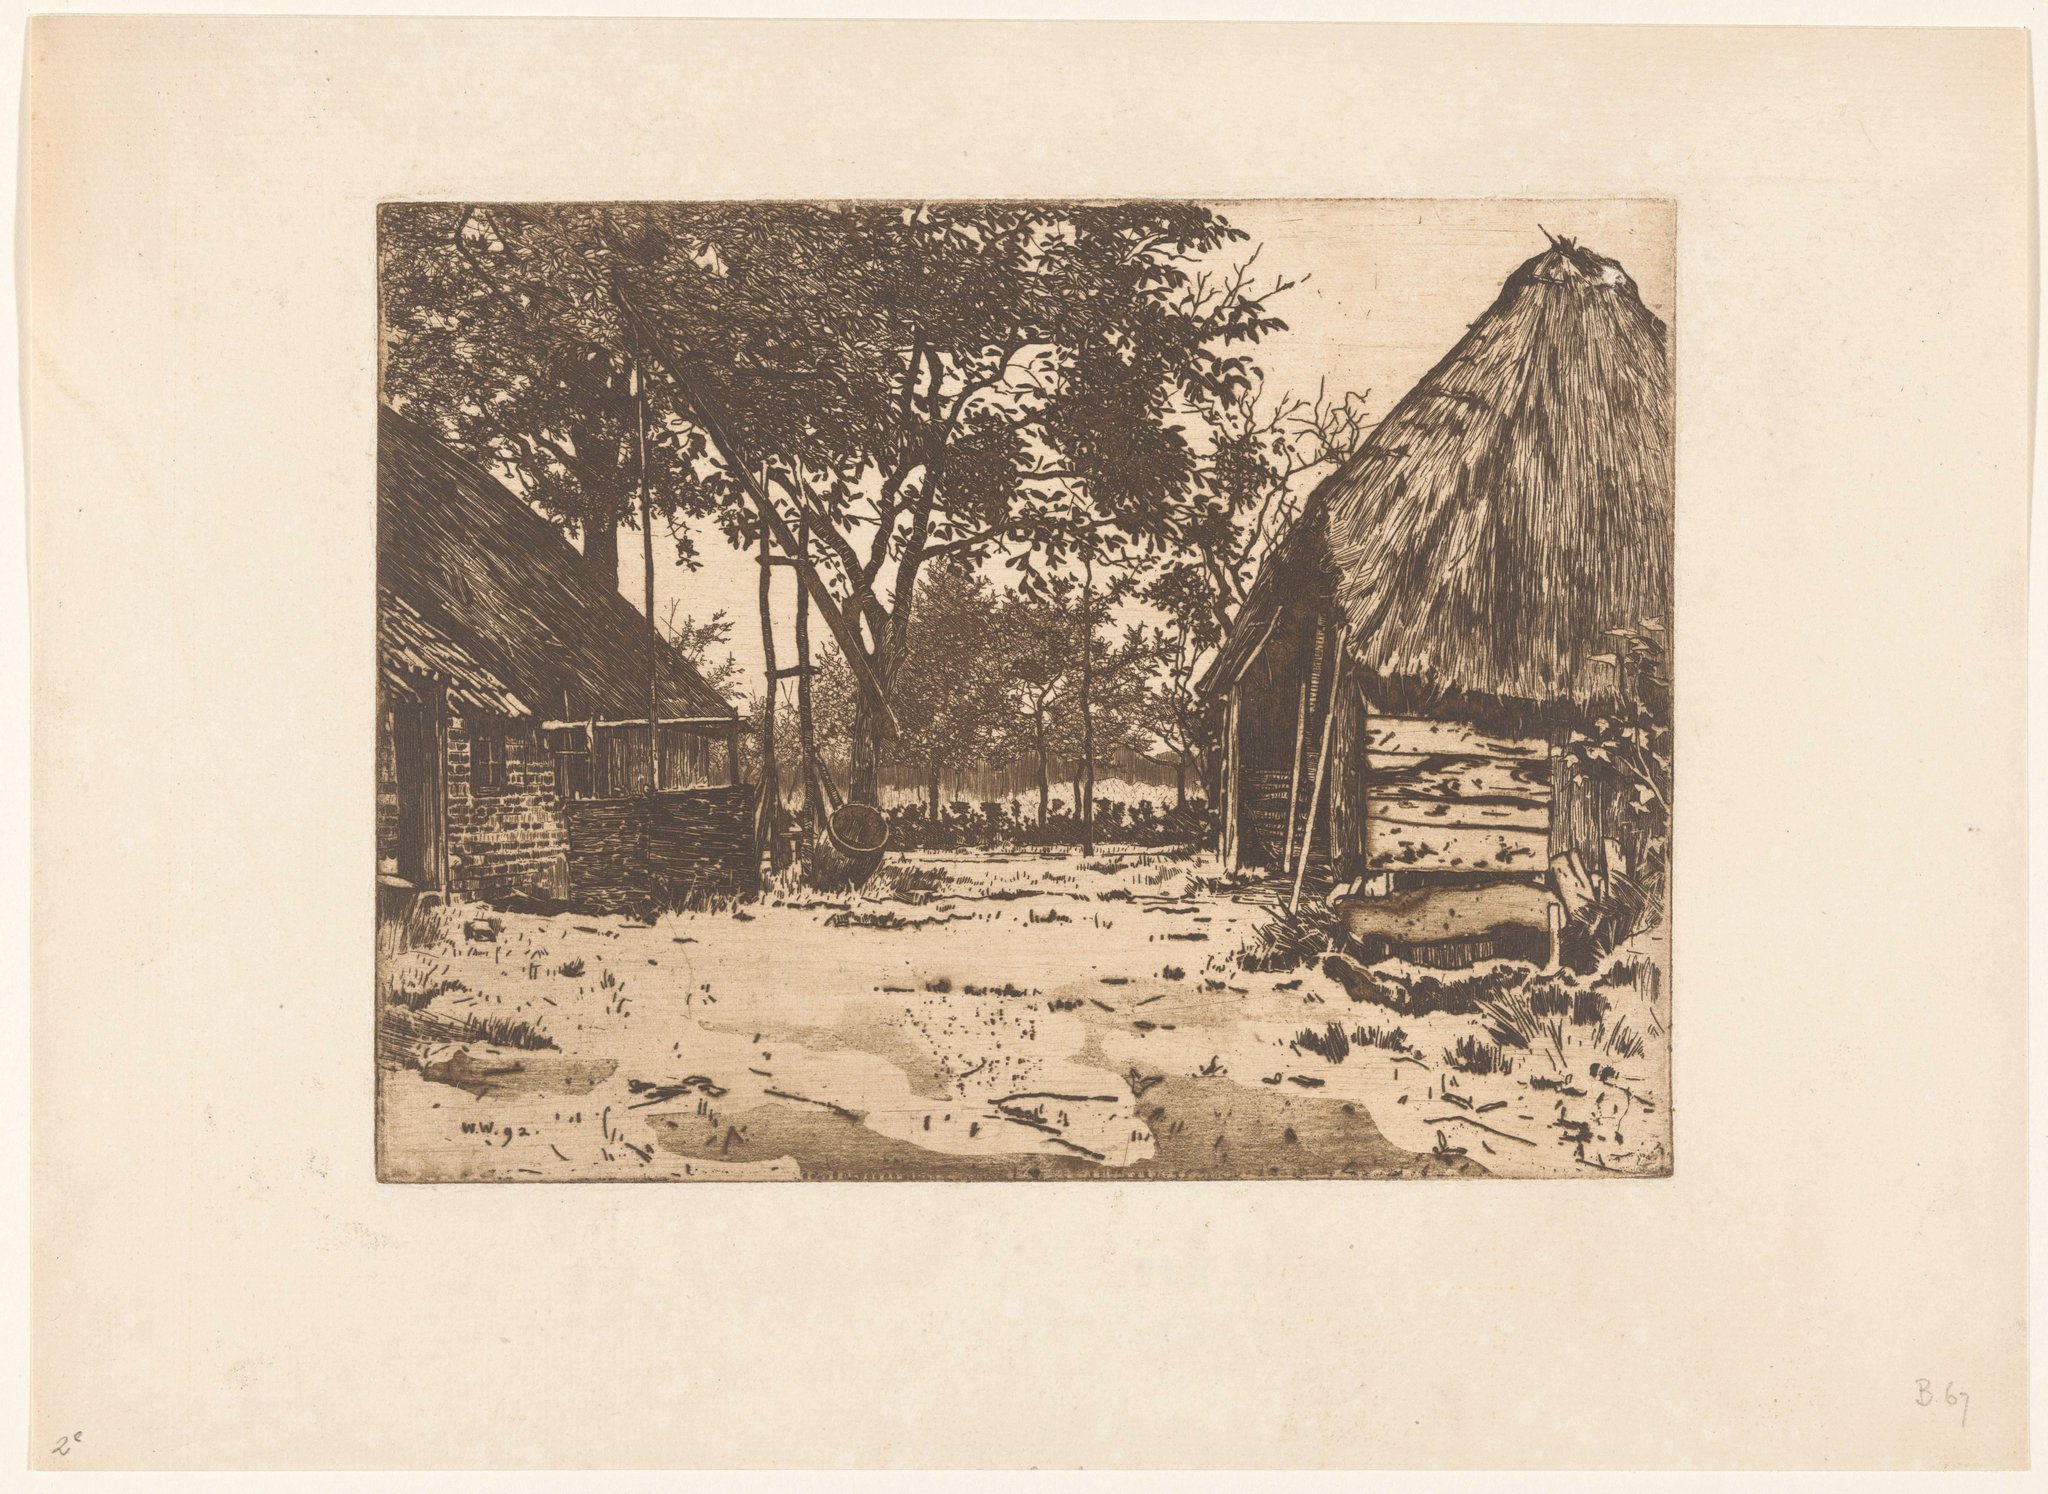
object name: print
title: Boerenerf in Brabant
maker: willem witsen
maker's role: draughtsman, painter, print maker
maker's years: 1860-1923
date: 1892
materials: paper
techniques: etching, intaglio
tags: barn, farm (building)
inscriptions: watermark